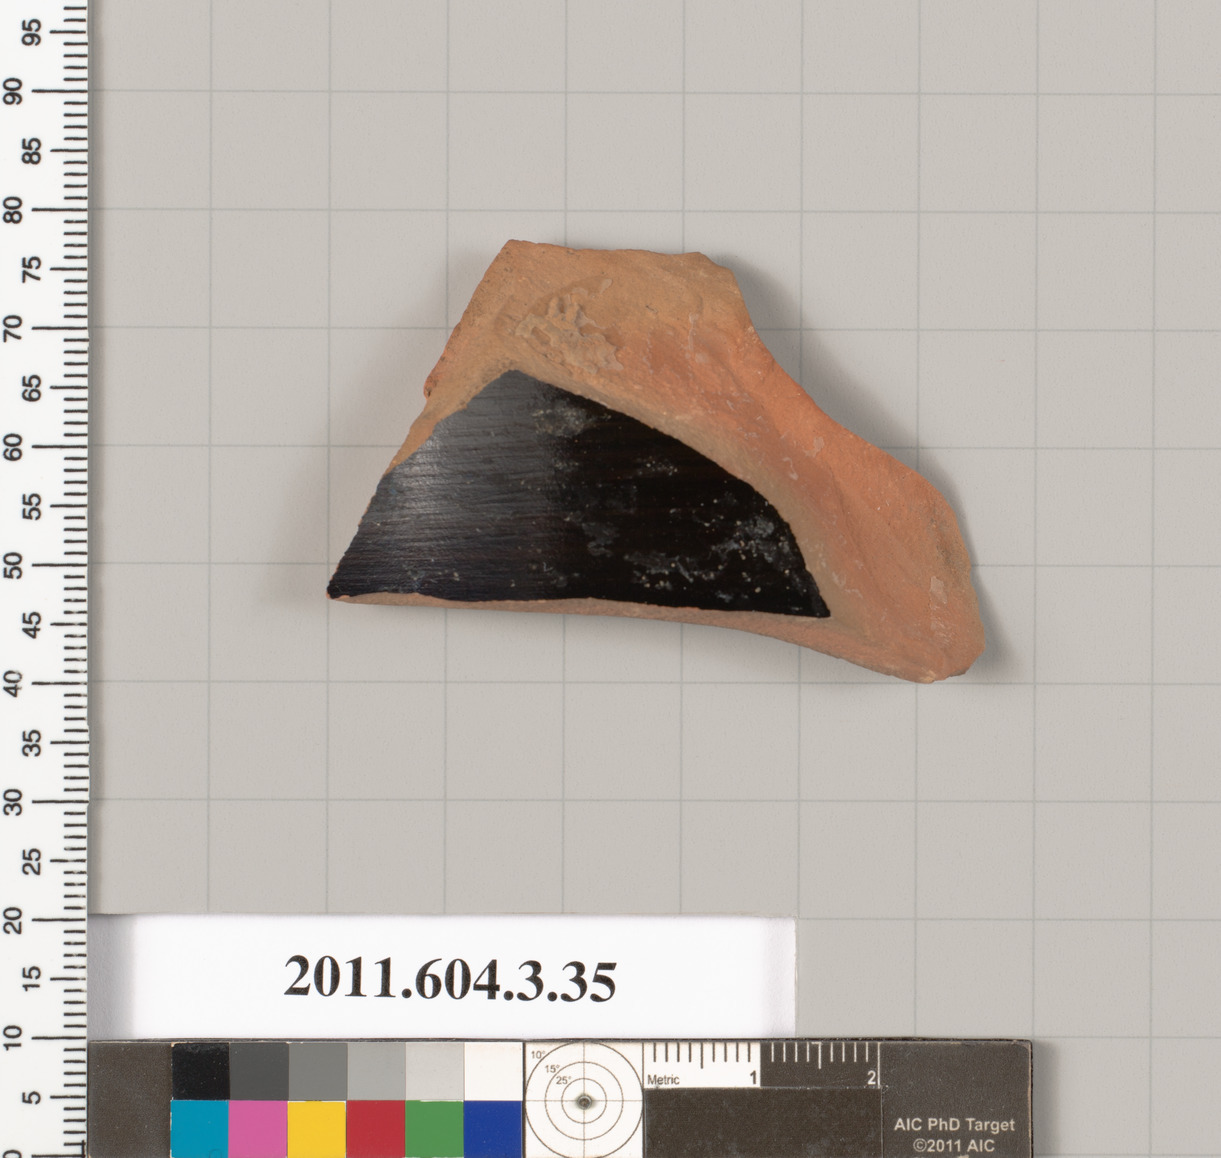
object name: pot fragment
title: Terracotta fragment of a pot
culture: greek, attic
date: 600-501 BCE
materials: terracotta